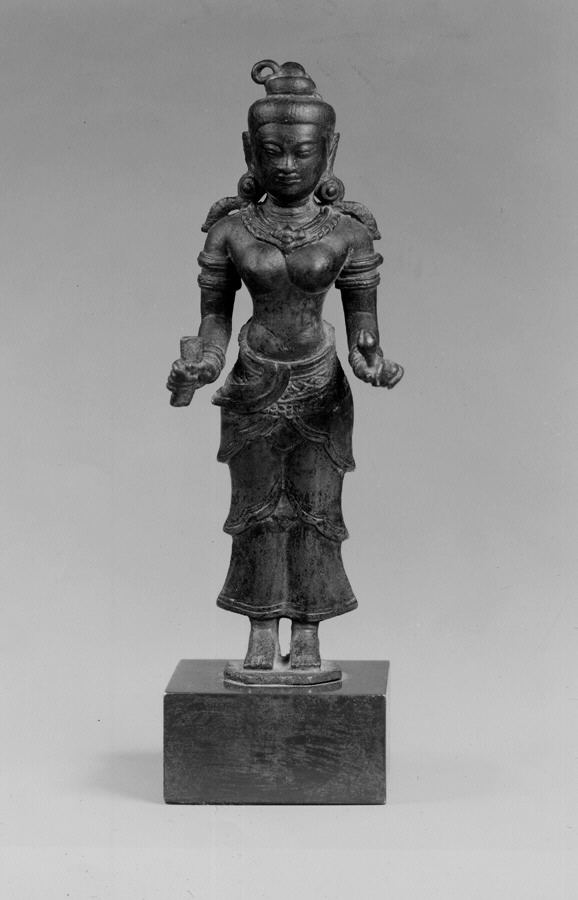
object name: figure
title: Standing Prajnaparamita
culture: thai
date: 1201-1300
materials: bronze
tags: deities